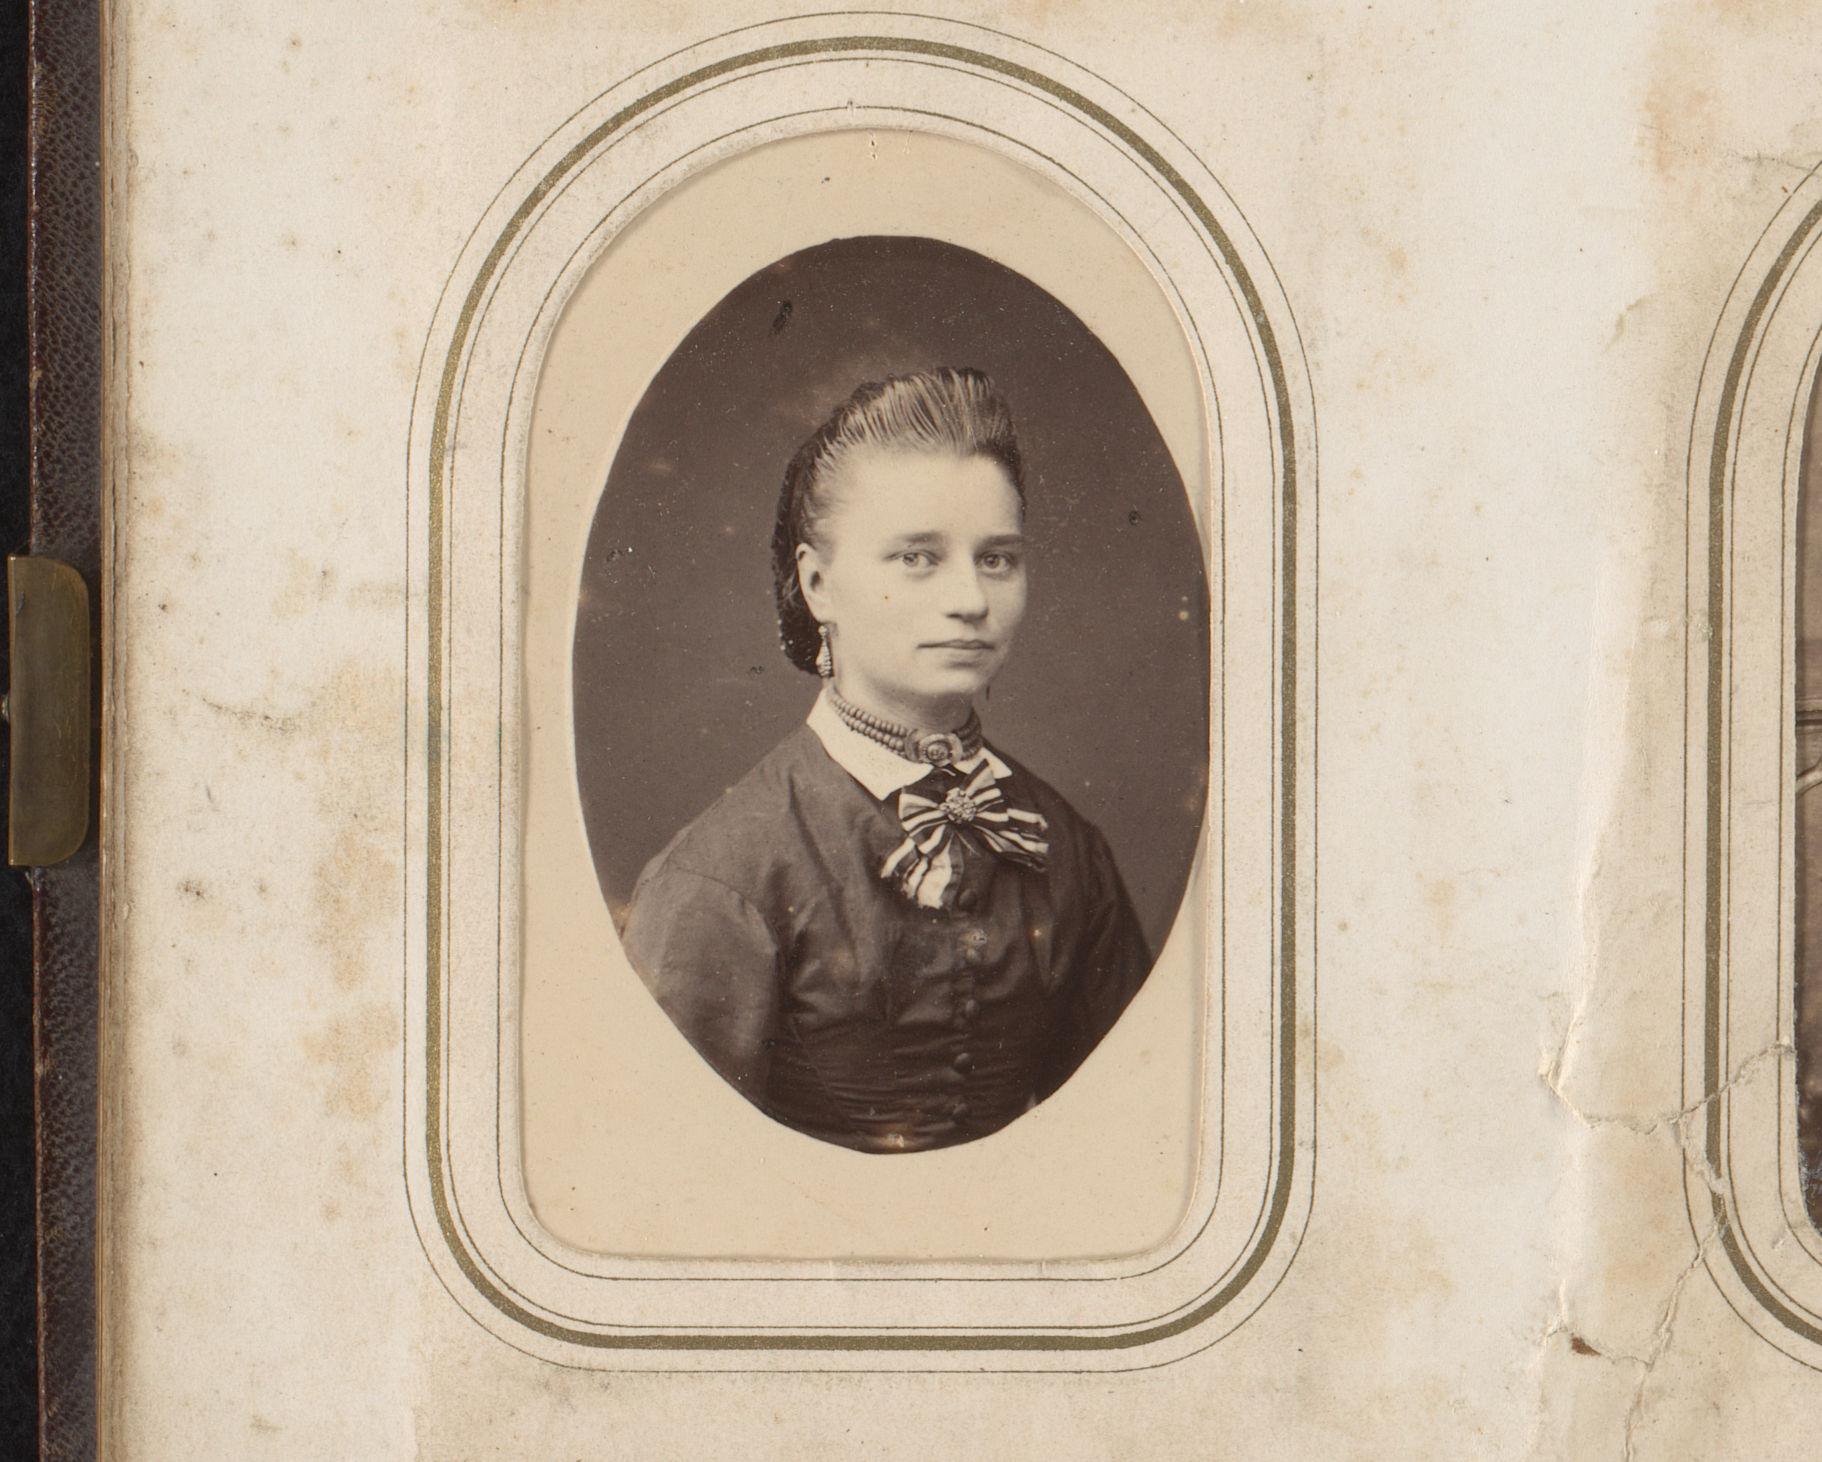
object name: semi enamel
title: Portret van een jonge vrouw met halsketting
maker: willem gerhardus kuijer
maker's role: fotograaf, hoffotograaf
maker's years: 1834-1899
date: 1862-1899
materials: cardboard, celluloid, photographic support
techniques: albumen print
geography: amsterdam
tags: adolescent, young woman, maiden, historical persons - bb - woman, necklace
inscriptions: inscription: ‘W. G. KUIJER/ Photograaph/ Amsterdam/ Rozengracht 72.’